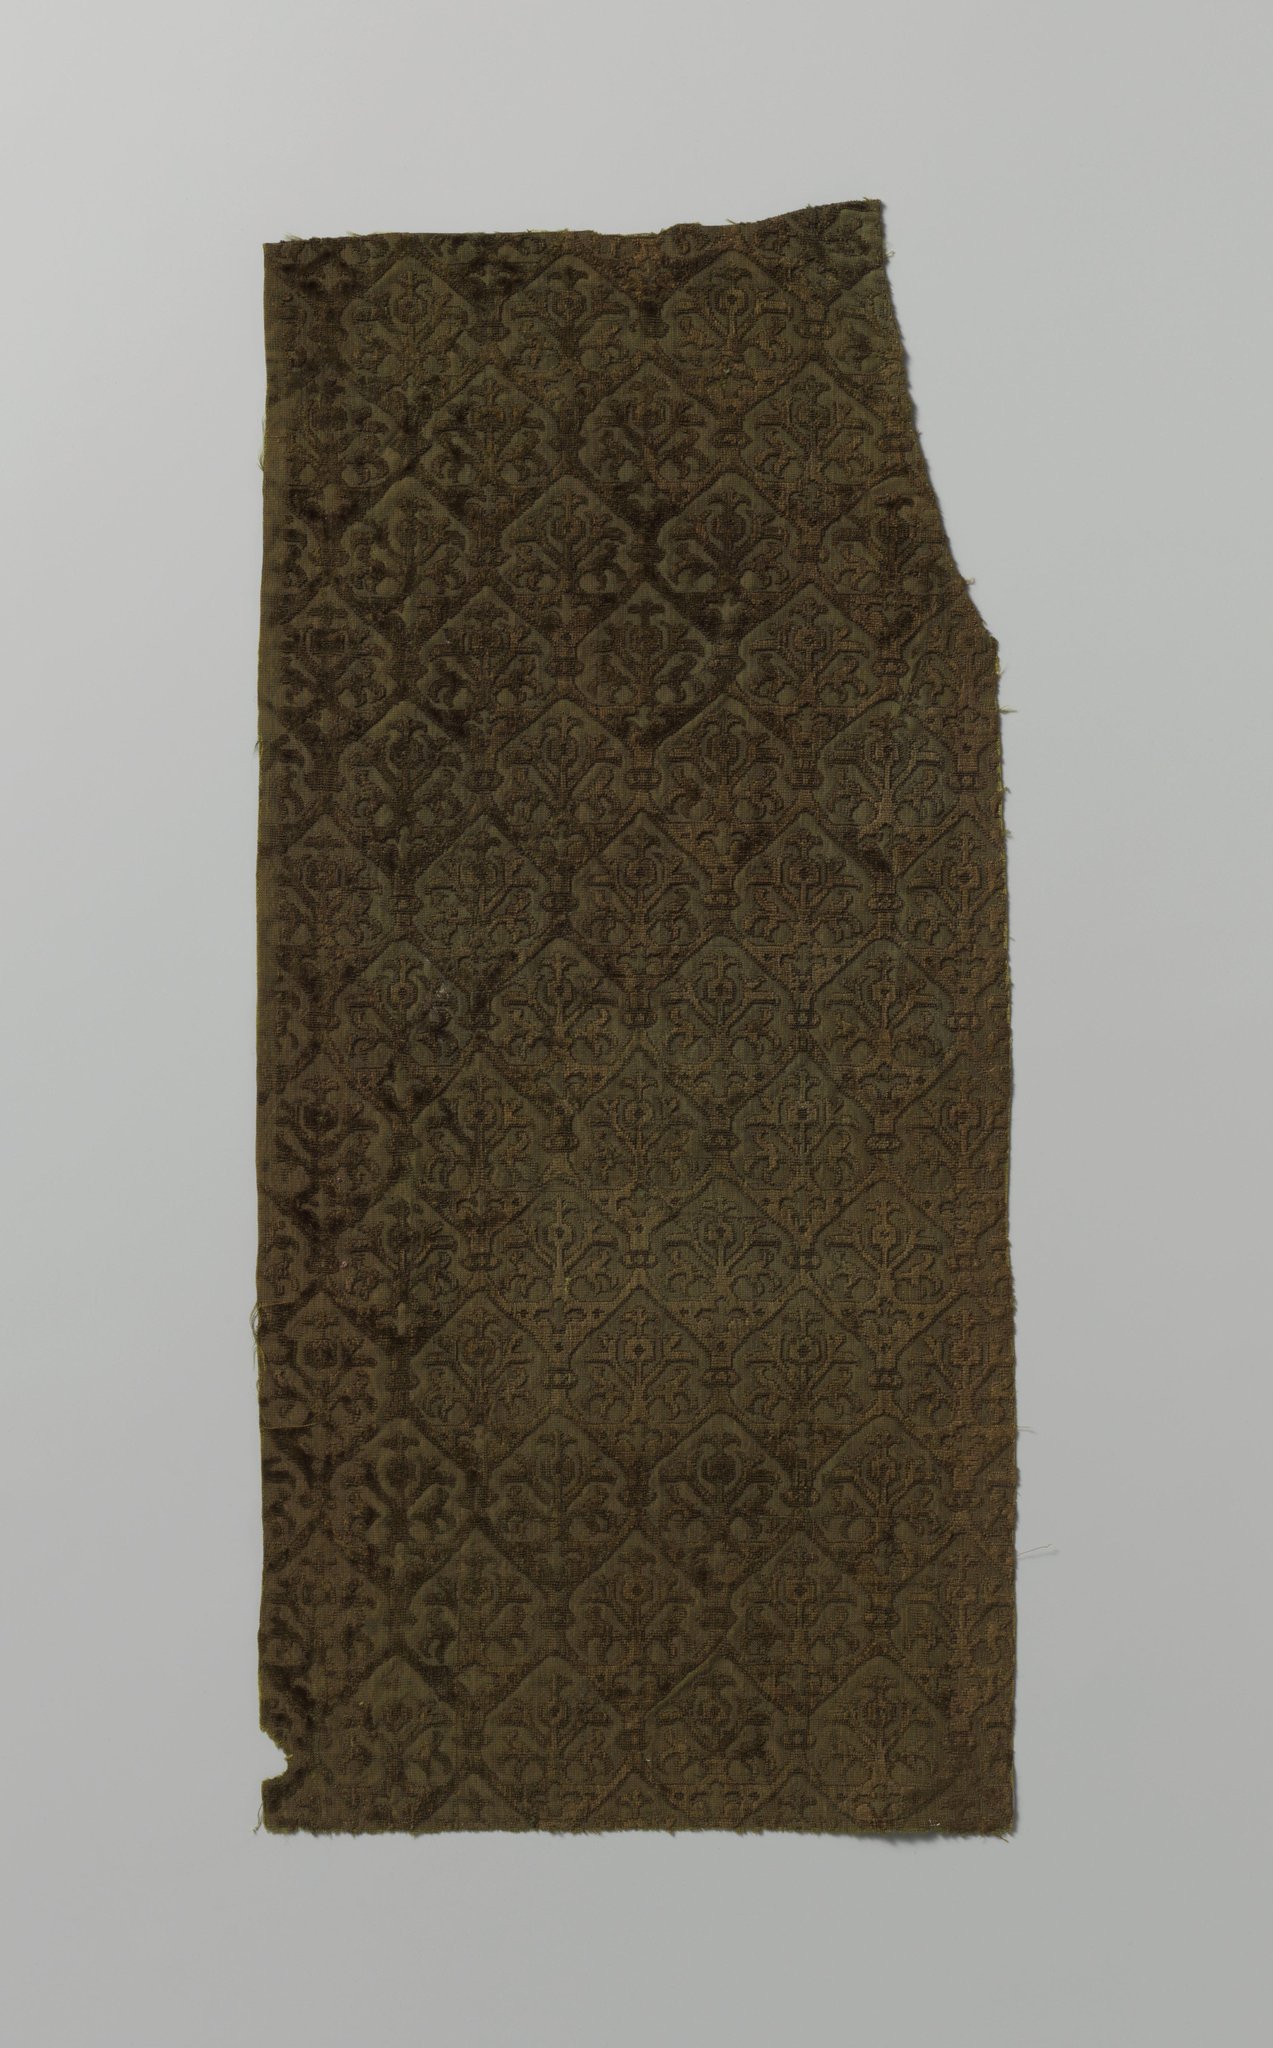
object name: zijdefluweel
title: Fragment zijdefluweel met gestileerde florale motieven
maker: Anonymous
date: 1500-1599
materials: silk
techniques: velvet, weave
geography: italy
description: Fragment zijdefluweel met op groene grond in rijen uitgesparde hartvormen met granaatbloesem.